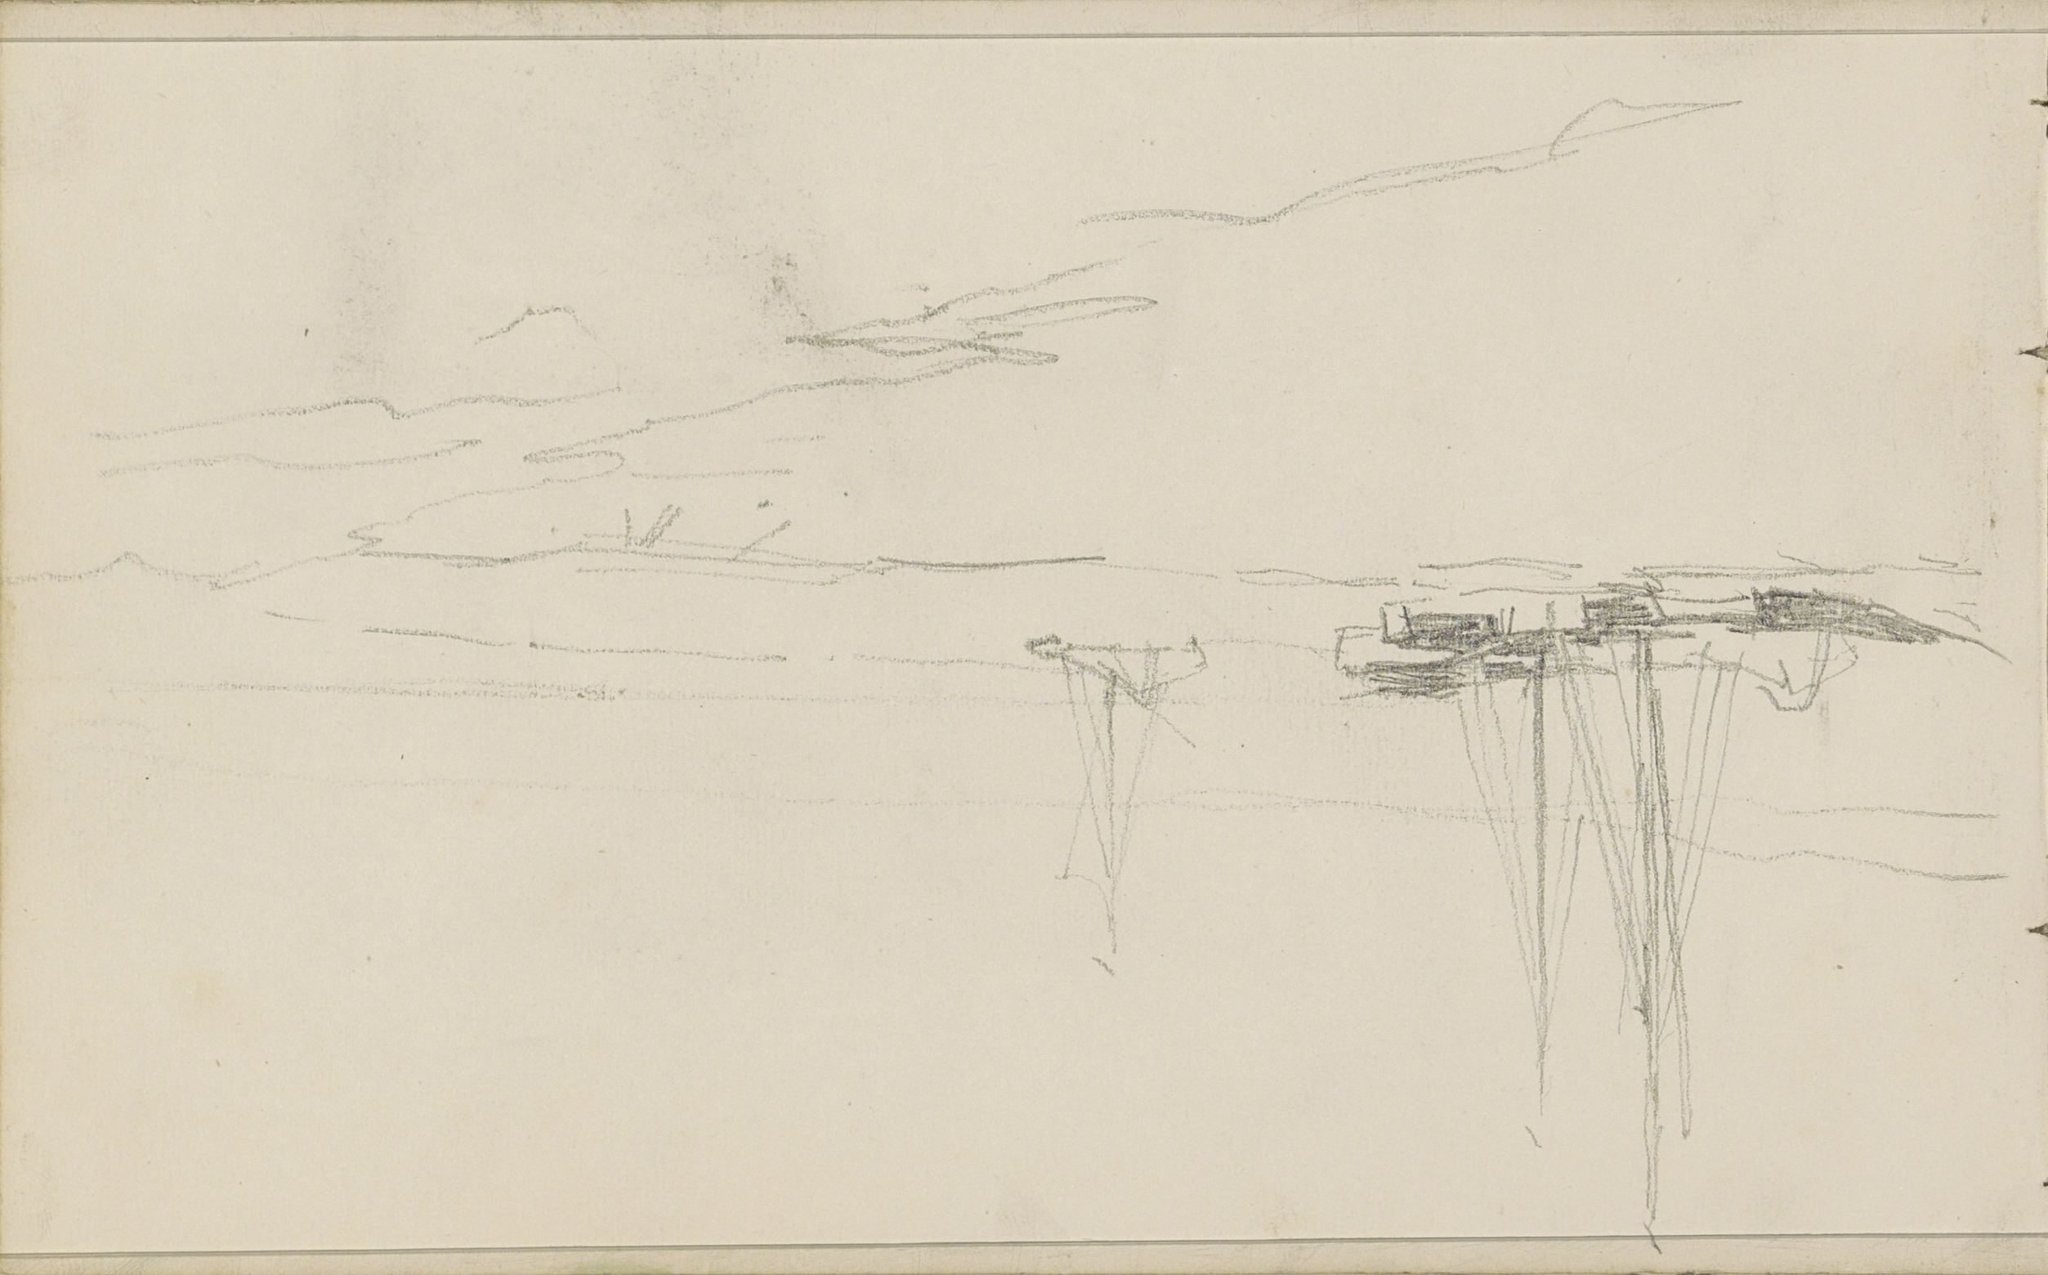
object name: sketchbook leaf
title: Zeilschepen op het water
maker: anton mauve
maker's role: draughtsman, painter, print maker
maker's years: 1838-1888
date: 1848-1888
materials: paper, pencil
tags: sailing-ship, sailing-boat, landscapes with waters, waterscapes, seascapes (in the temperate zone)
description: Blad 9 verso uit een schetsboek met 42 bladen.